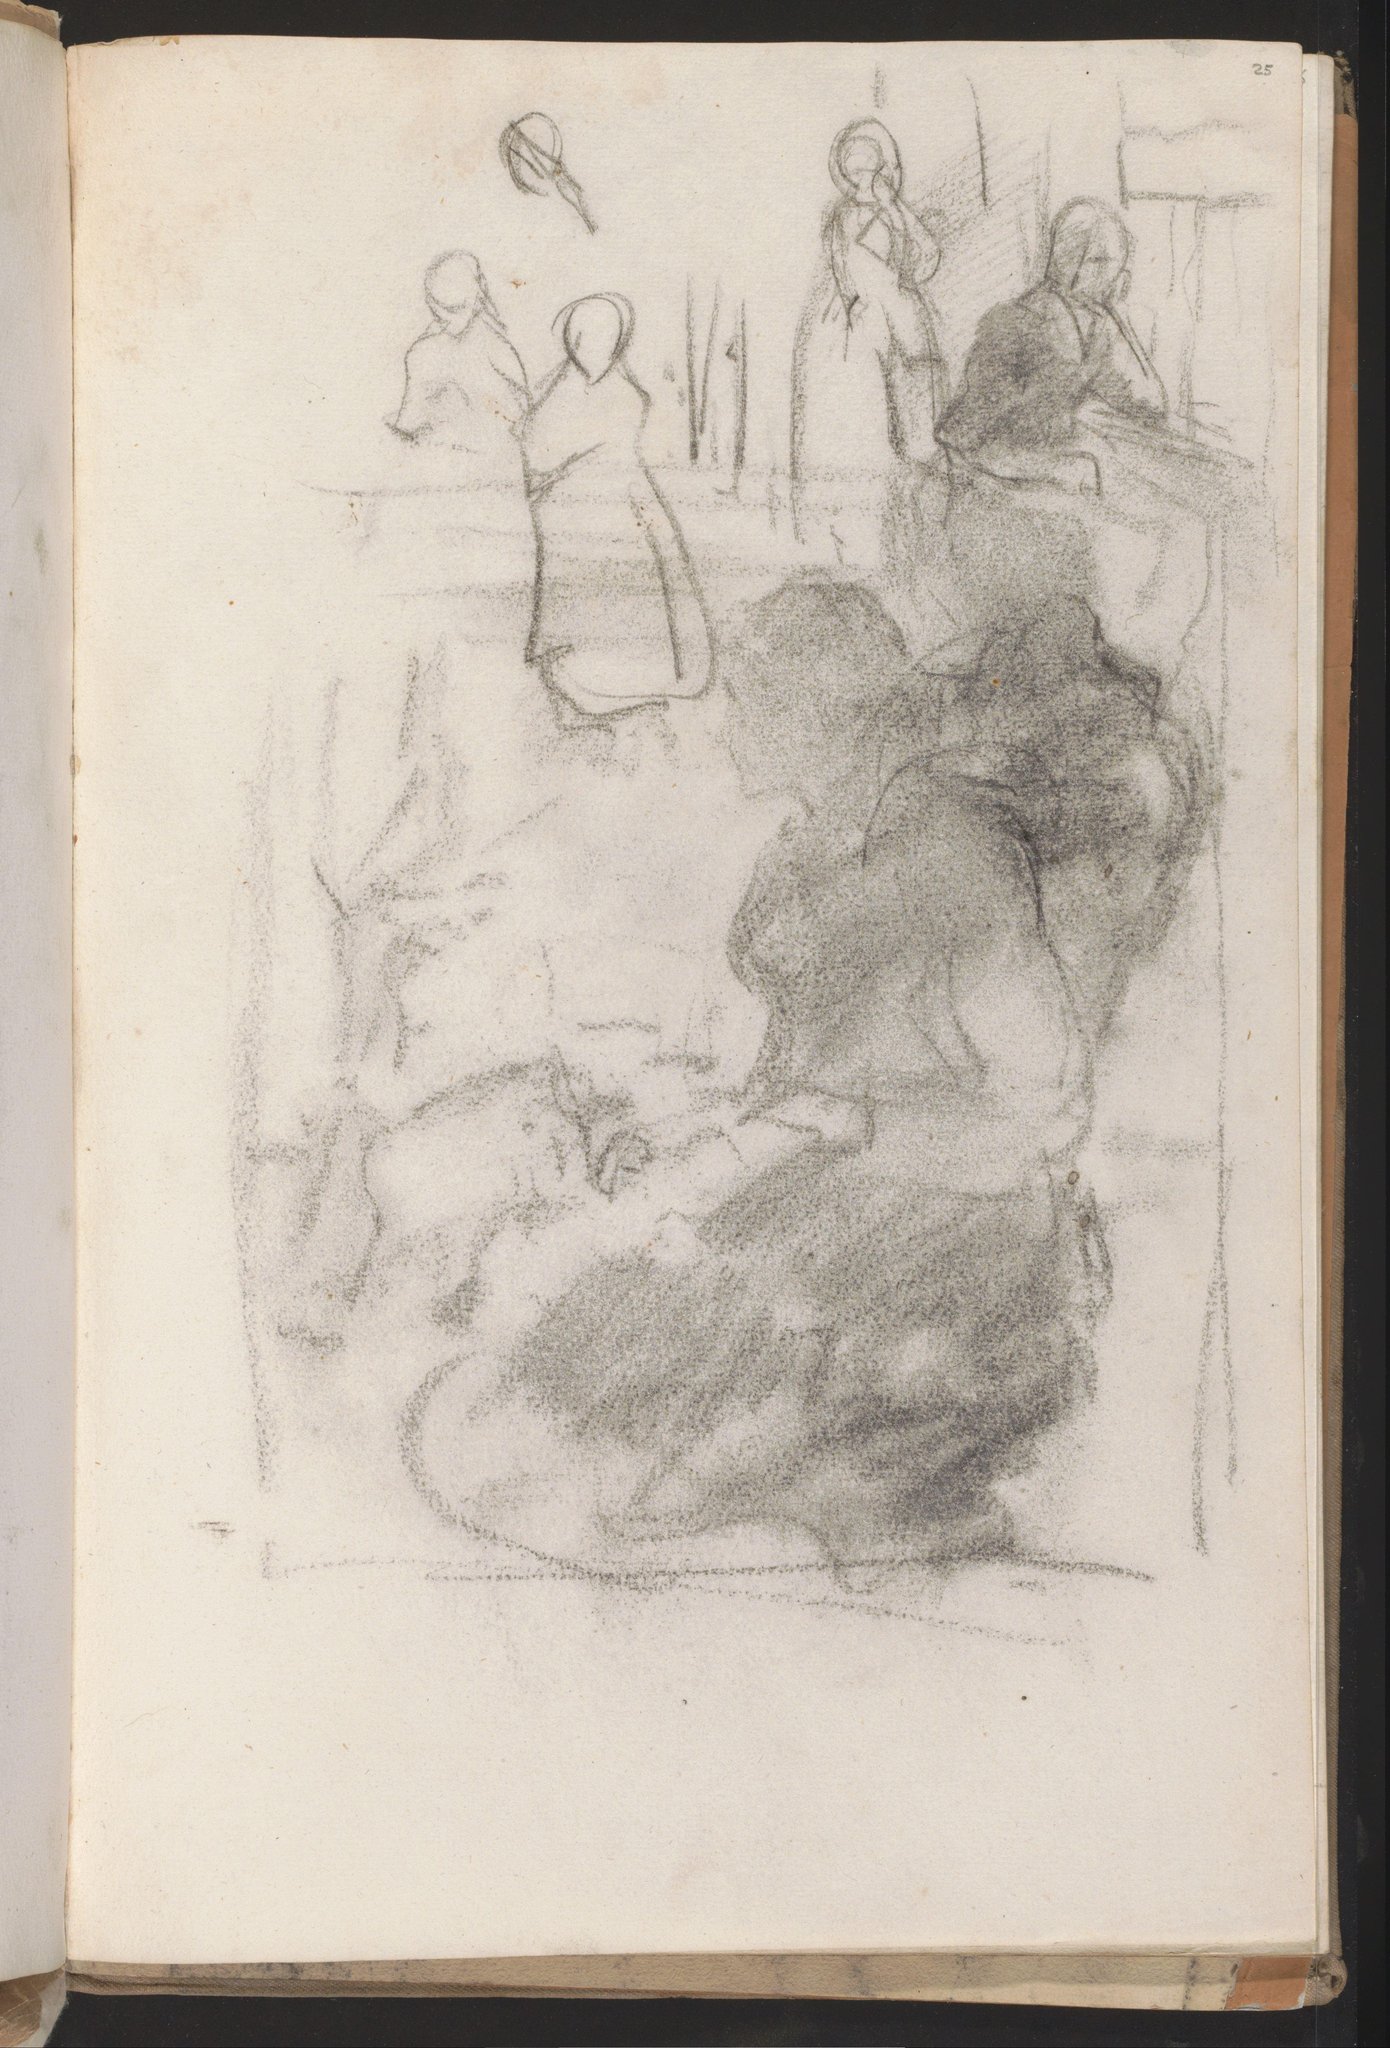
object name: sketchbook leaf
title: Knielende vrouw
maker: albert neuhuys (1844-1914)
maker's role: draughtsman, painter, print maker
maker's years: 1844-1914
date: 1854-1914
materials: charcoal, paper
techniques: stumping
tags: sitting figure, adult woman, adult man, kneeling figure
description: Op de achtergrond enkele figuren, zoals een man zittend aan een tafel. Blad 25 recto uit een schetsboek met 53 bladen.